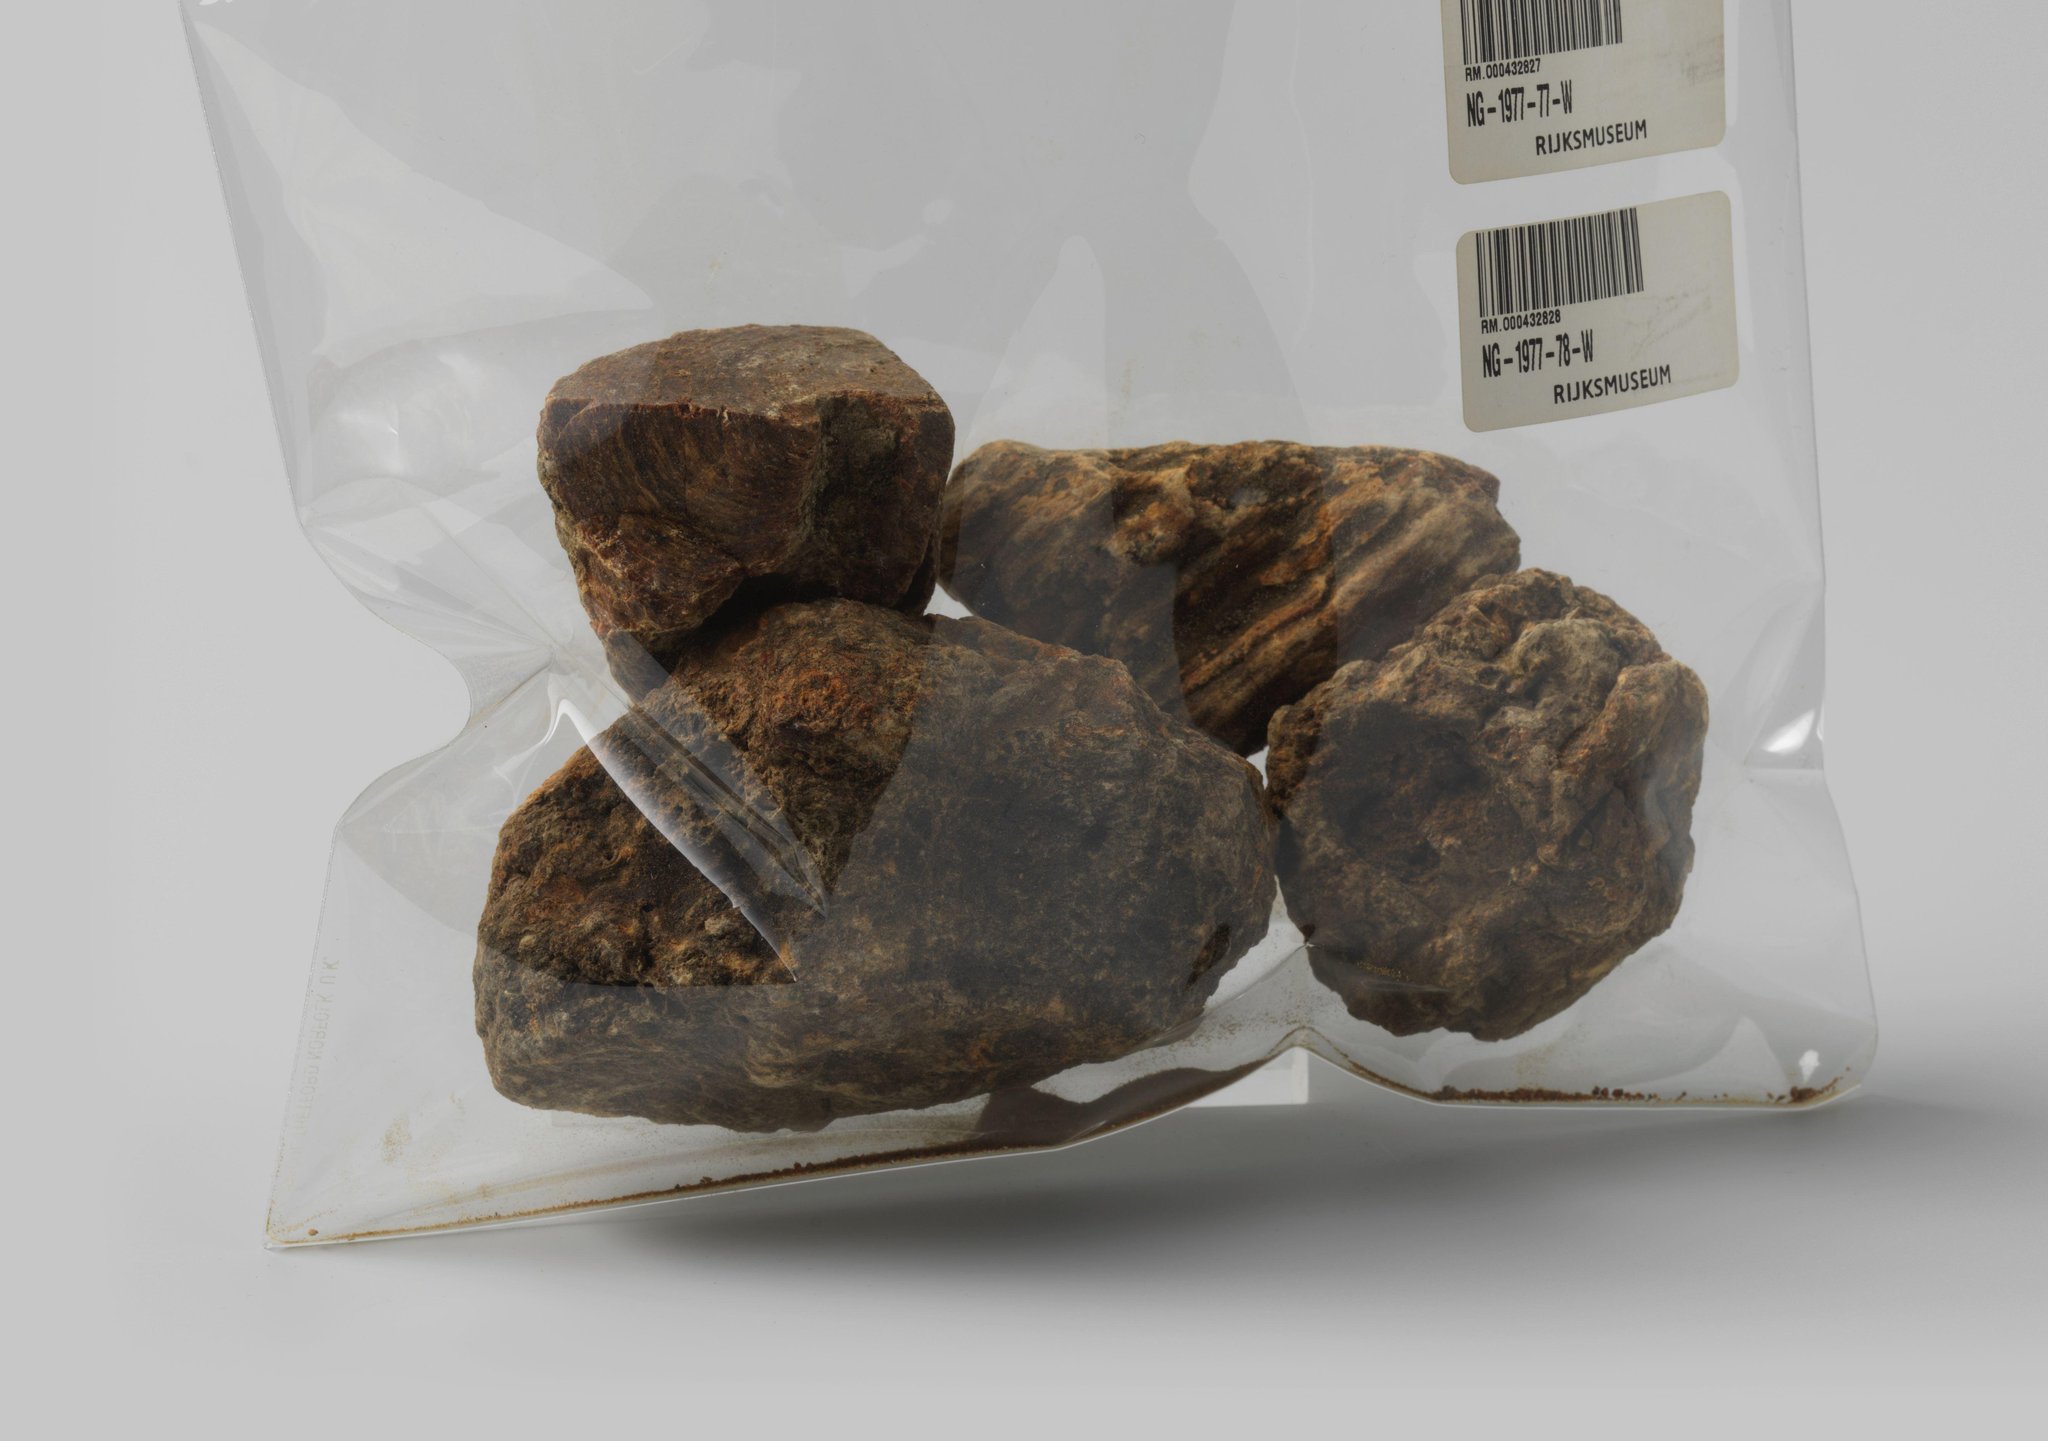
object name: artifact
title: Brok uit V.O.C.-schip de 'Witte Leeuw'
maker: Anonymous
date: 1613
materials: pigment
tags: verenigde oostindische compagnie, sint-helena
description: Brok uit V.O.C.-schip de 'Witte Leeuw', loodwit, grondstof voor verf.